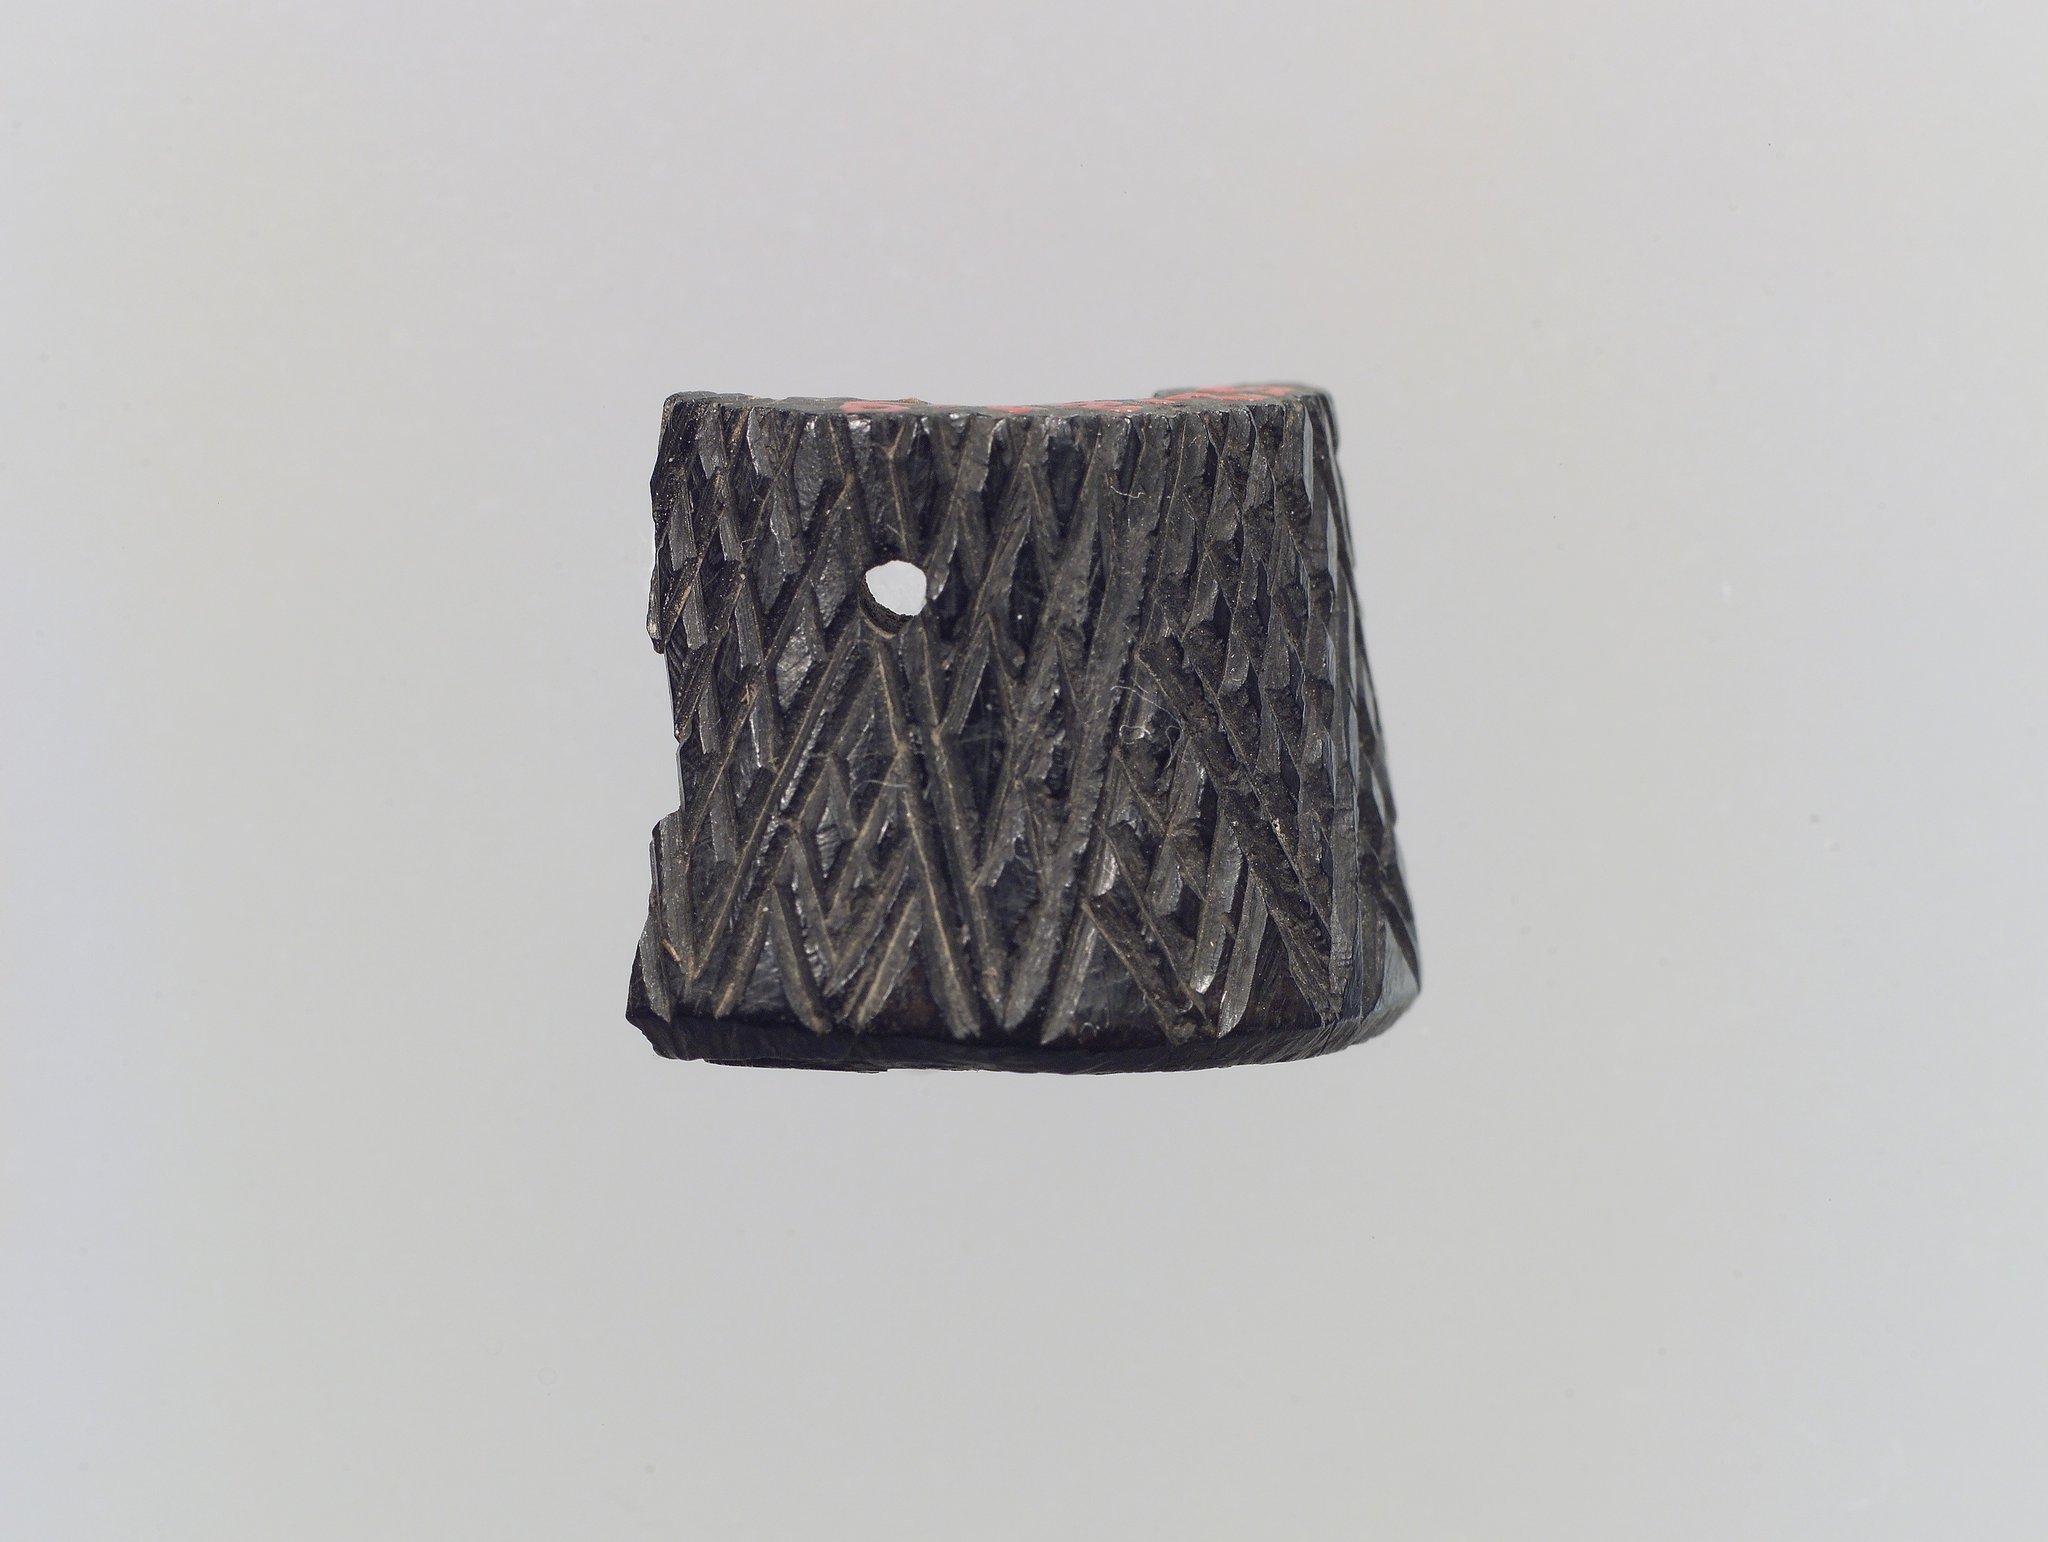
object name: relief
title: Ivory fragment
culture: assyrian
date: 800-601 BCE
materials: ivory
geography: mesopotamia